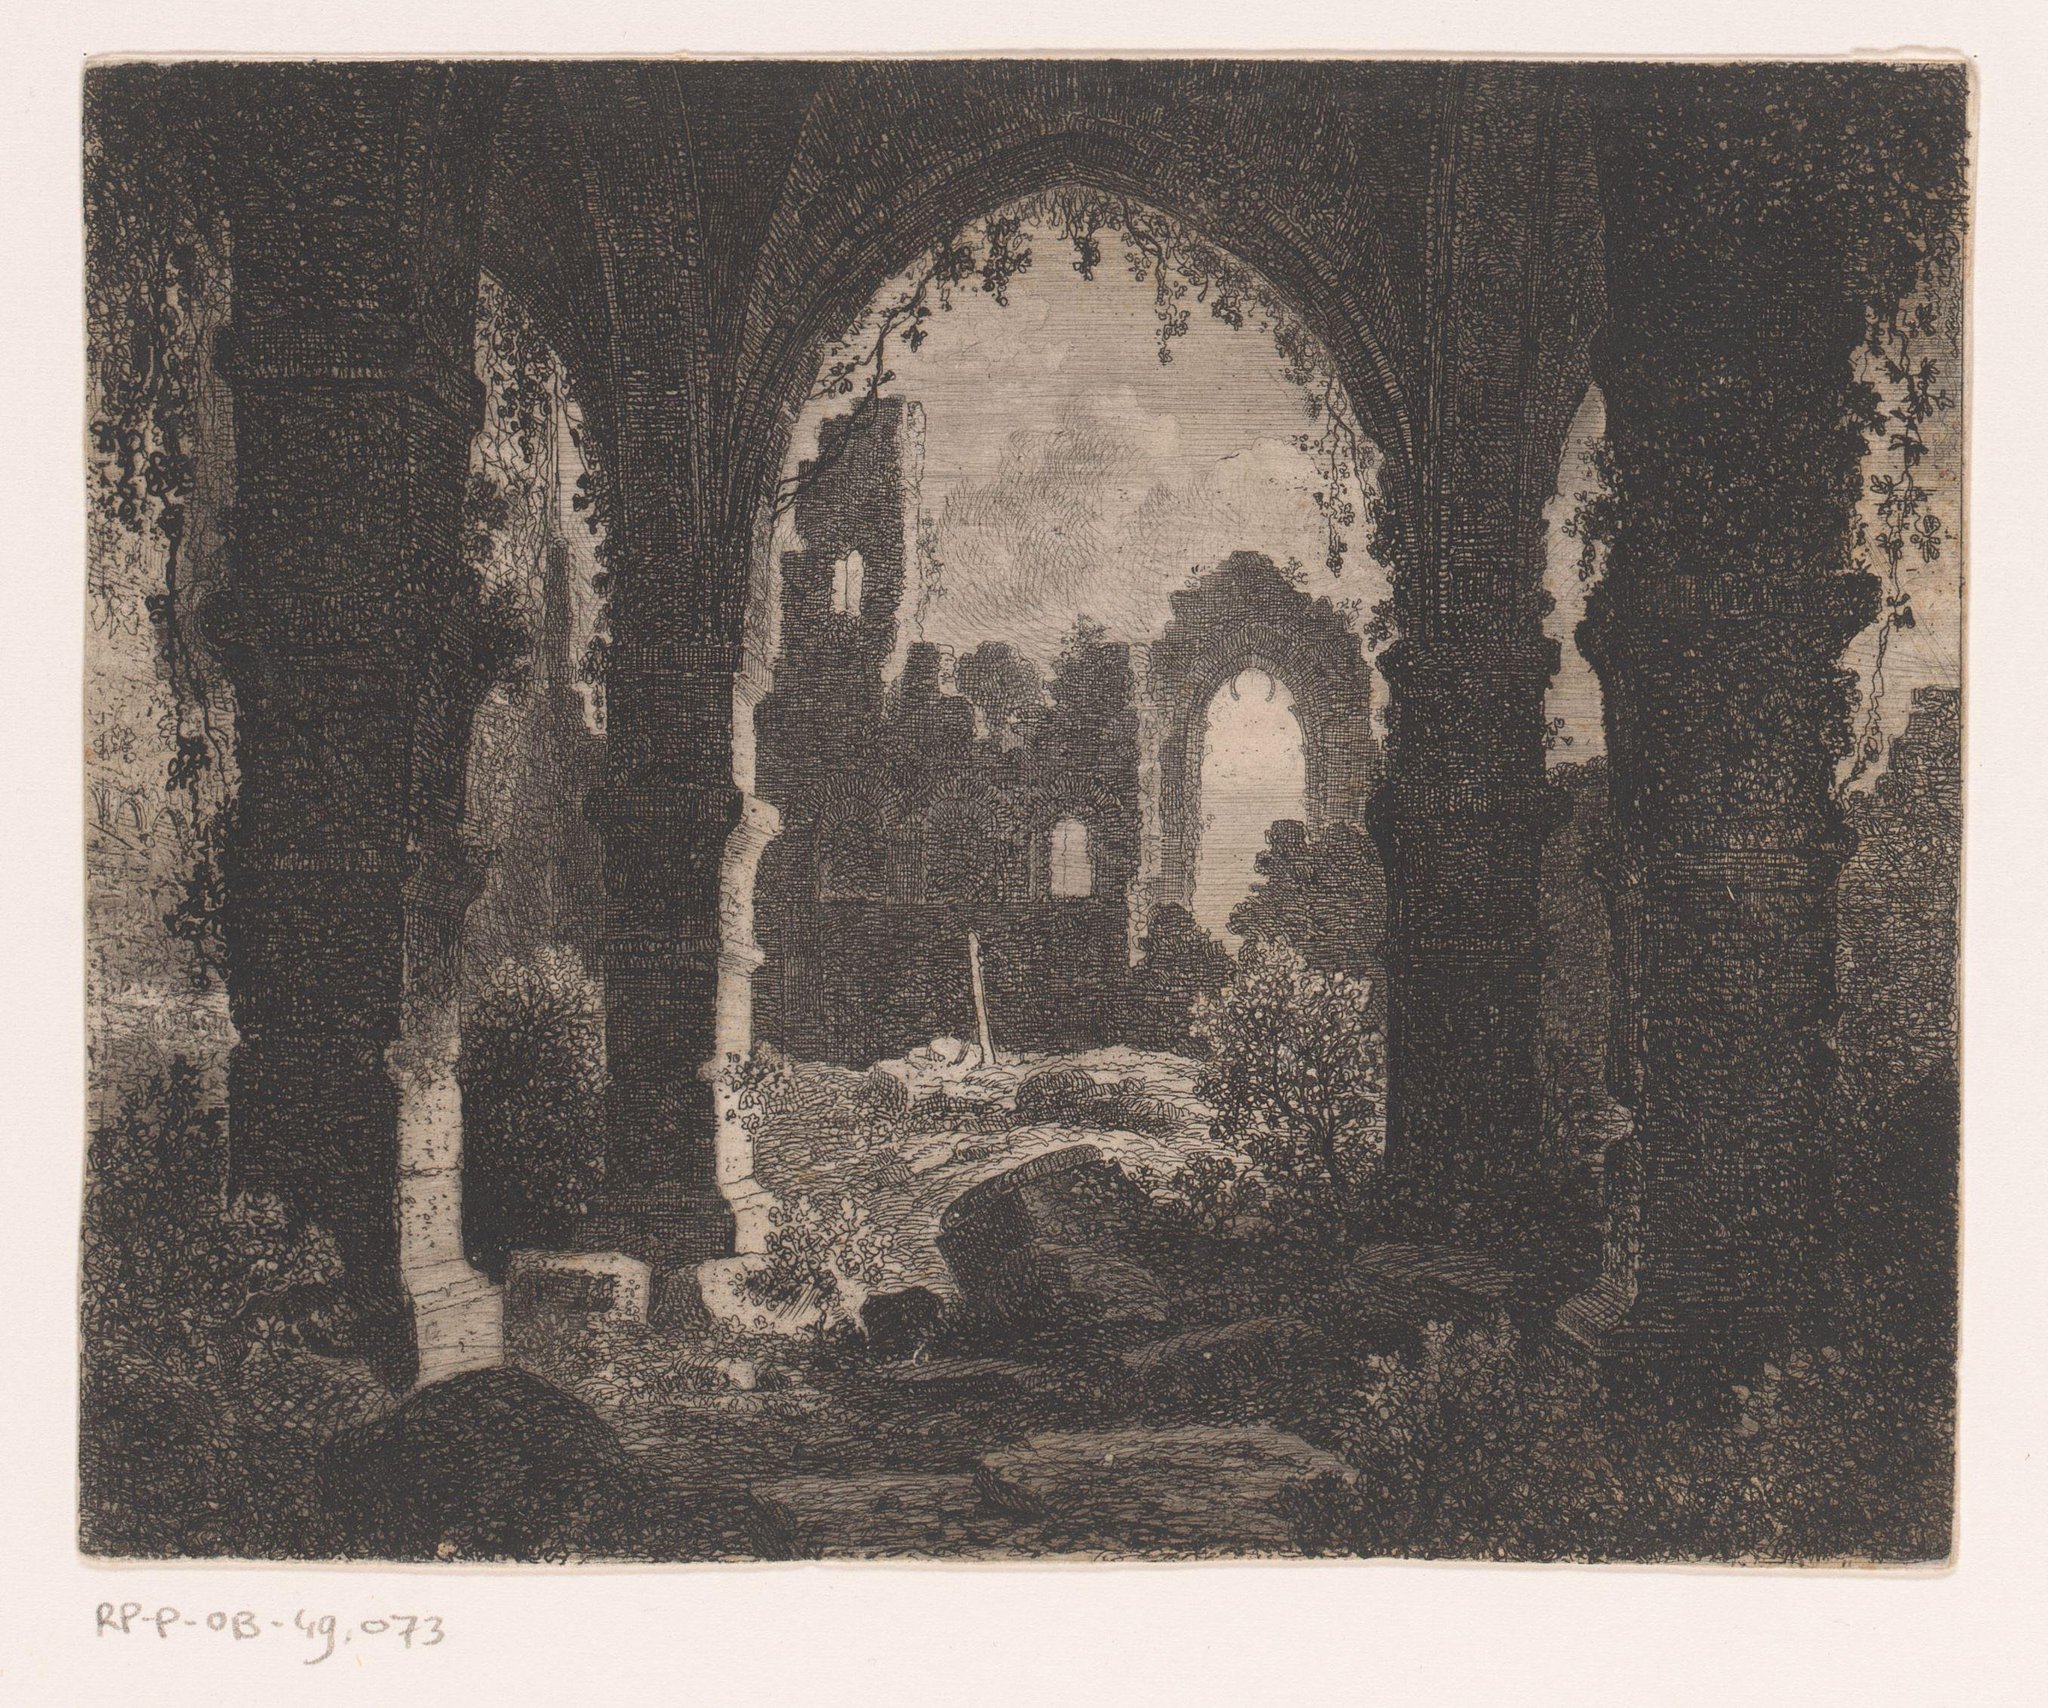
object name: print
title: Gezicht op de ruïne van kasteel Kenilworth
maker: guillaume van der hecht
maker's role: print maker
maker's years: 1817-1891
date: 1827-1879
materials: paper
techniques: etching, intaglio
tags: landscape with tower or castle, ruin of a dwelling, house, castle, etc.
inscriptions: collector's mark: Lugt 2228